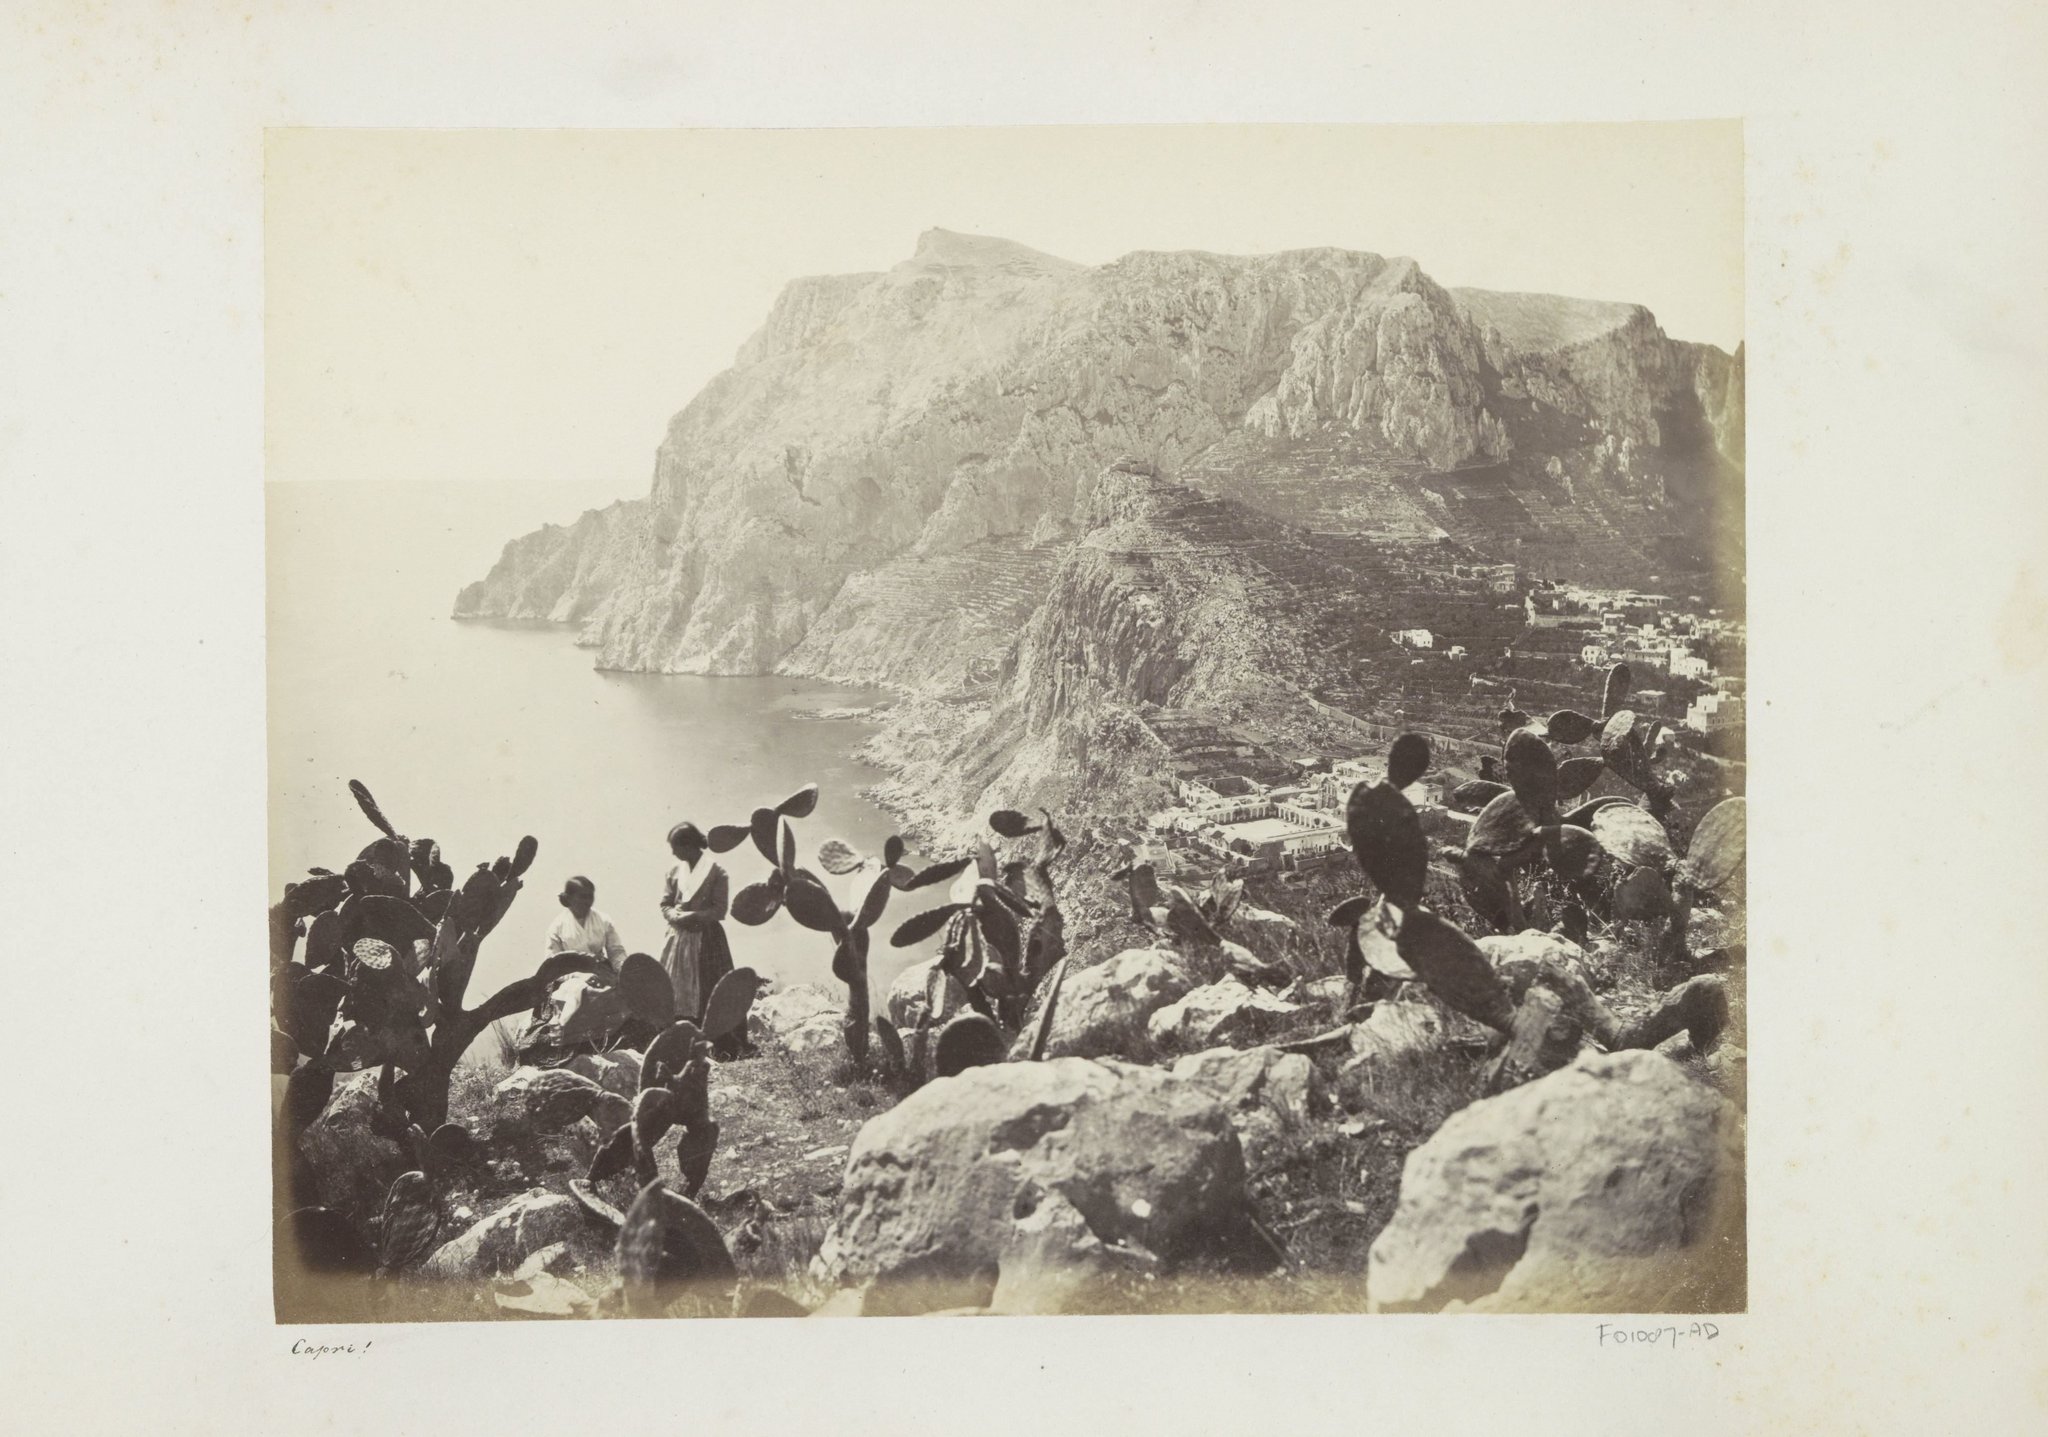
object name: photograph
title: Twee vrouwen op een rotskust met cactussen op Capri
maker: Anonymous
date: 1865-1875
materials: paper, photographic support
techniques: albumen print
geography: capri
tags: plants and herbs: cactus, coast, mountains, capri, isola di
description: Onderdeel van Reisalbum met foto's van bezienswaardigheden in Napels en omgeving.